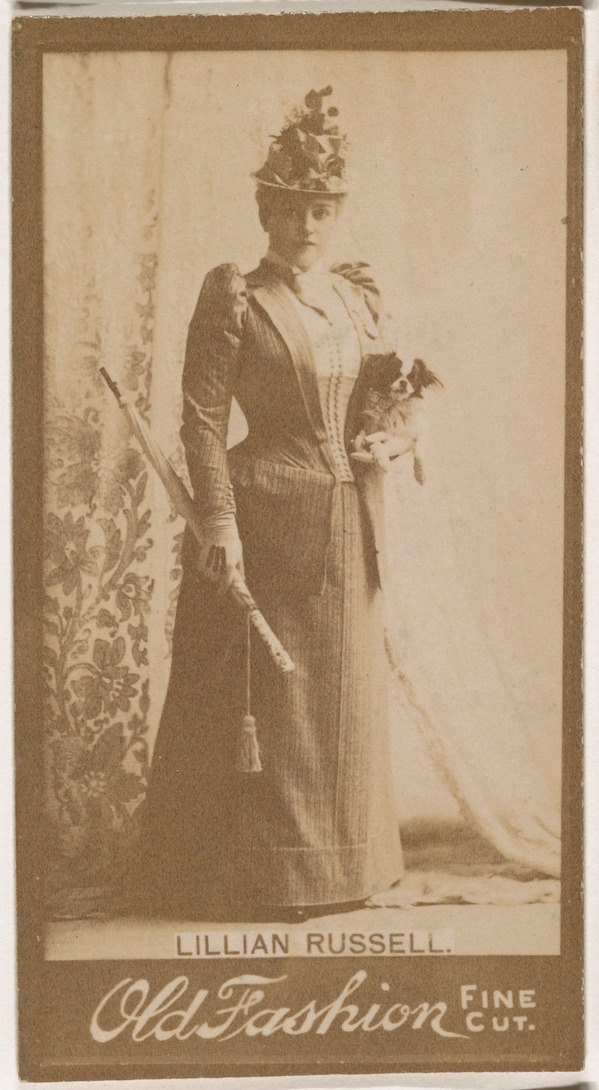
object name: photograph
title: Lillian Russell, from the Actresses series (N664) promoting Old Fashion Fine Cut Tobacco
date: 1888-1890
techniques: albumen silver print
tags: portraits,women,actresses